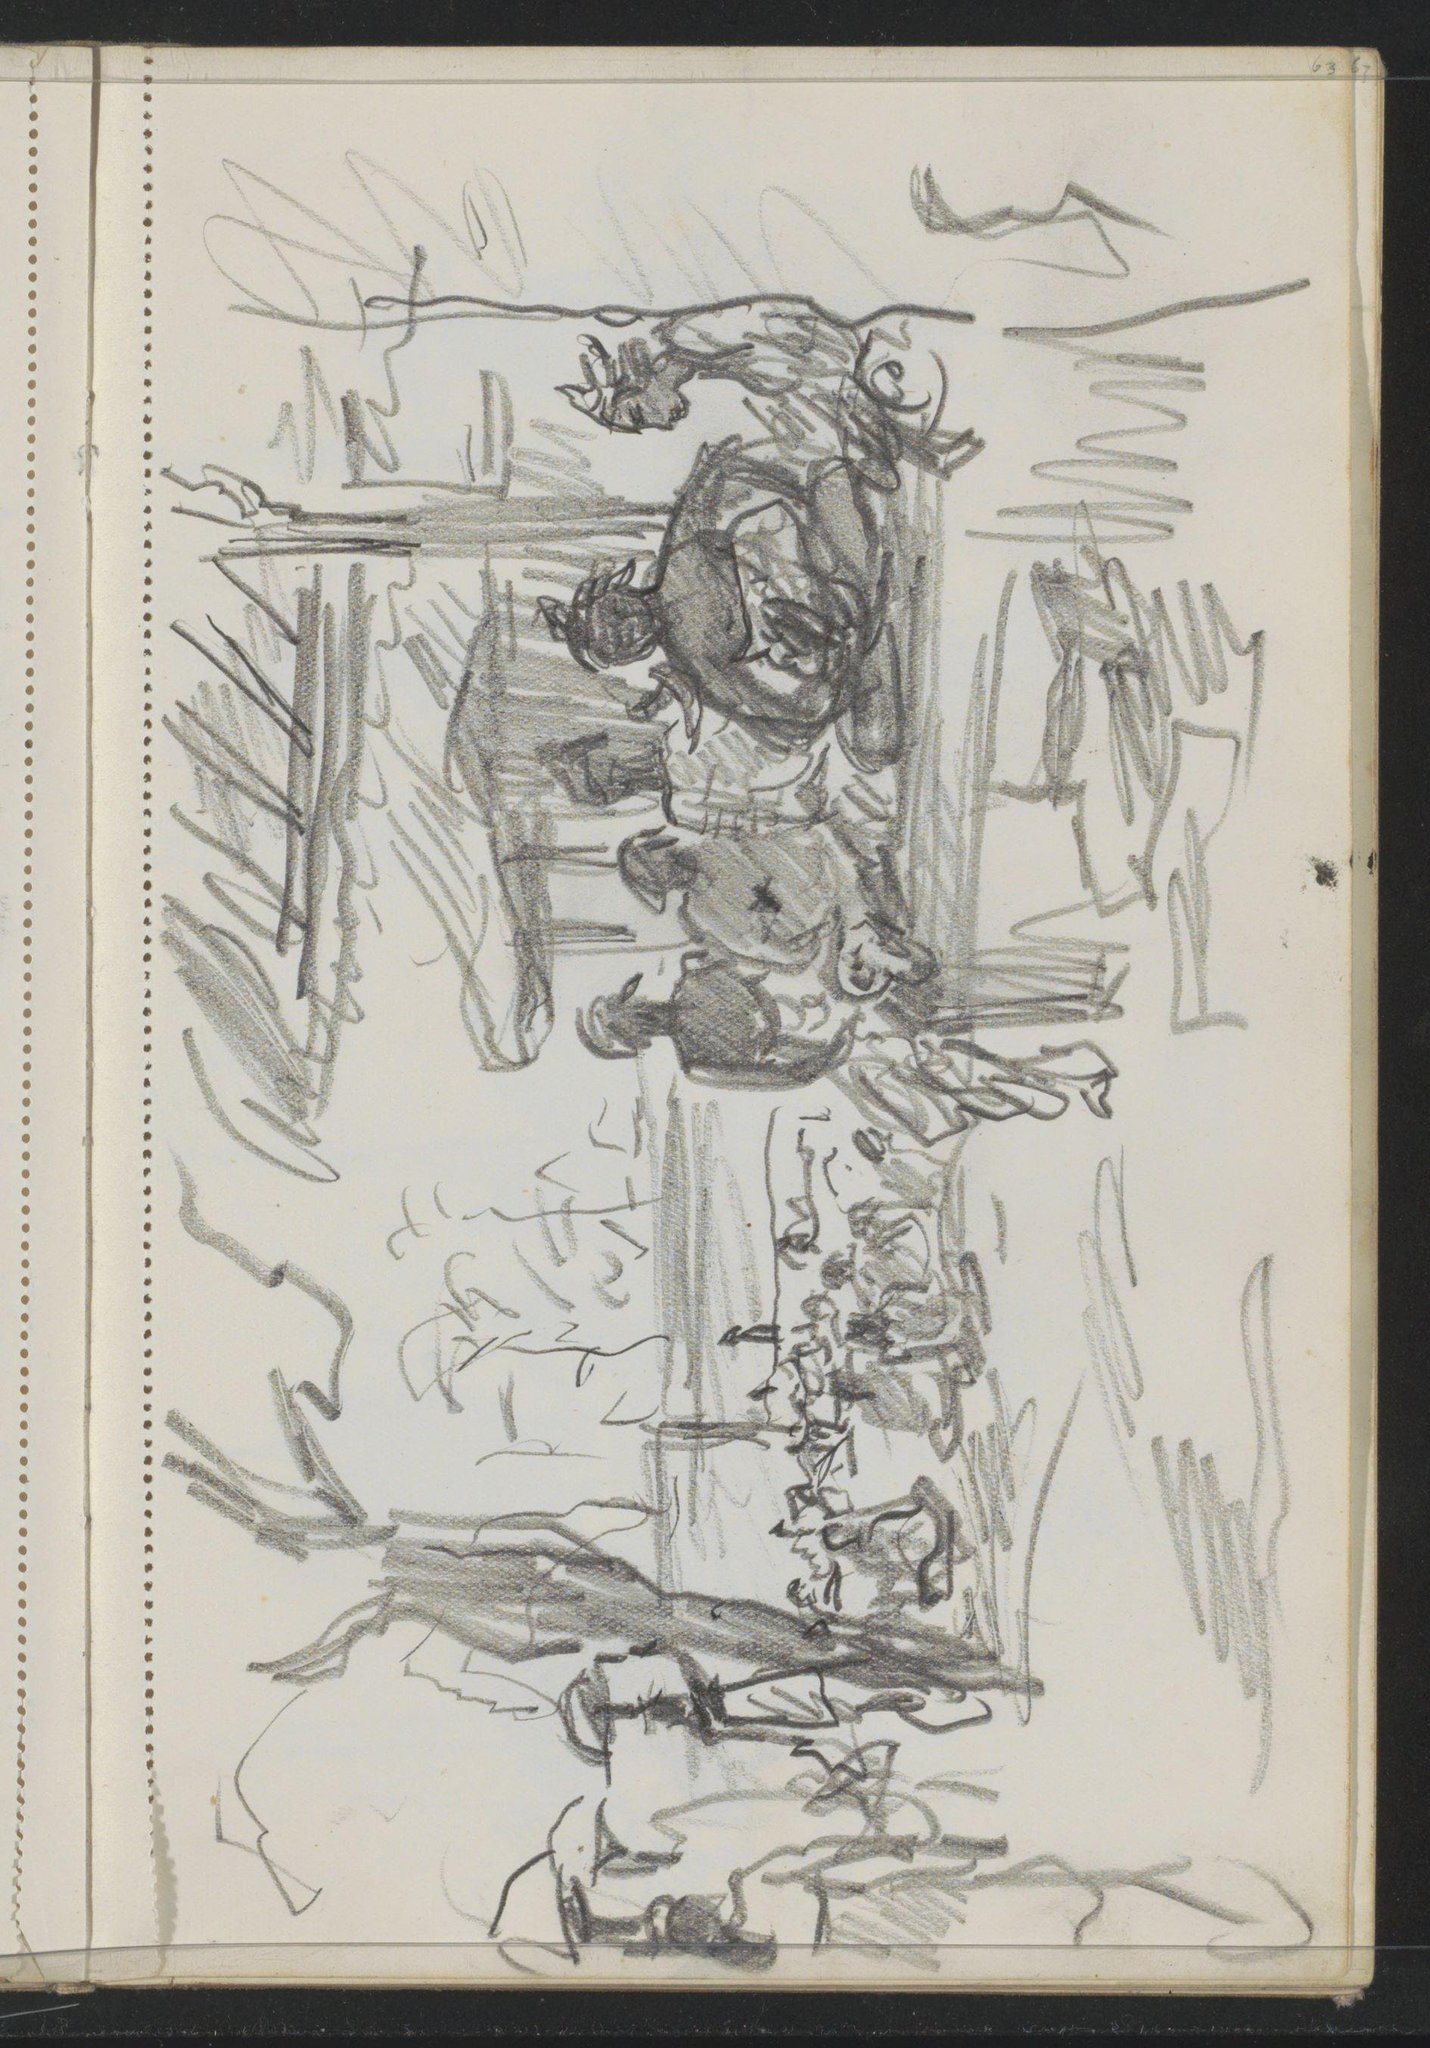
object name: sketchbook leaf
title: Landschap met zittende figuren op het gras en op een bank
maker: marius bauer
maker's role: draughtsman, print maker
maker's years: 1867-1932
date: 1925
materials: paper, pencil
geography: indonesia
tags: asiatic races and peoples, sitting figure, landscapes (+ landscape with figures, staffage)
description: Pagina 63 uit een schetsboek met 74 bladen.